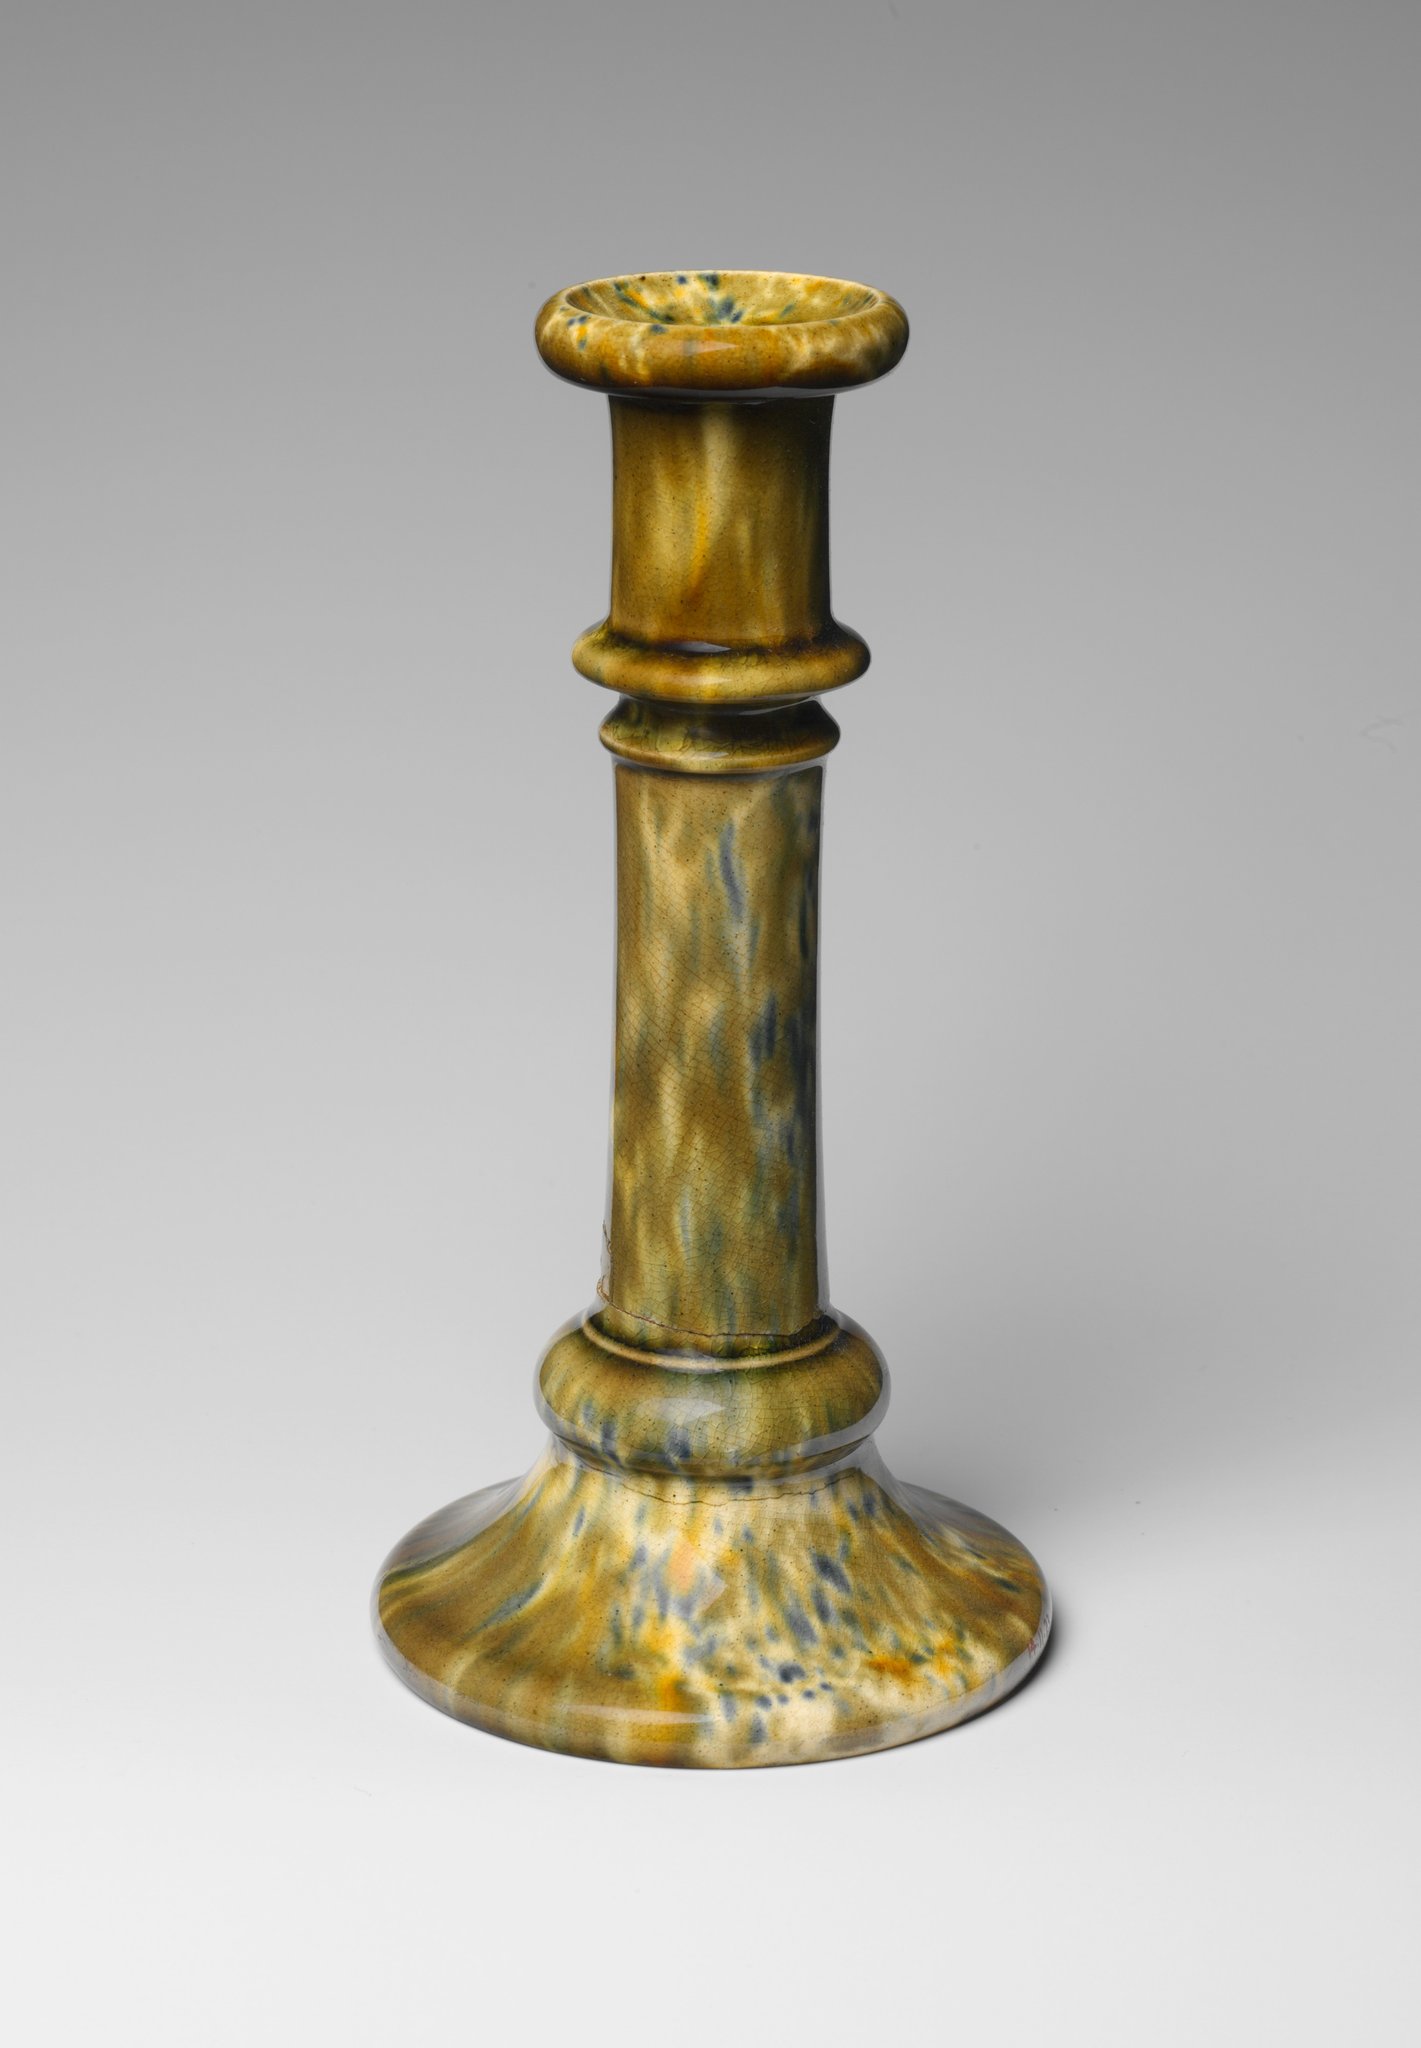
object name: candlestick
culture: american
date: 1830-1870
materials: earthenware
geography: united states